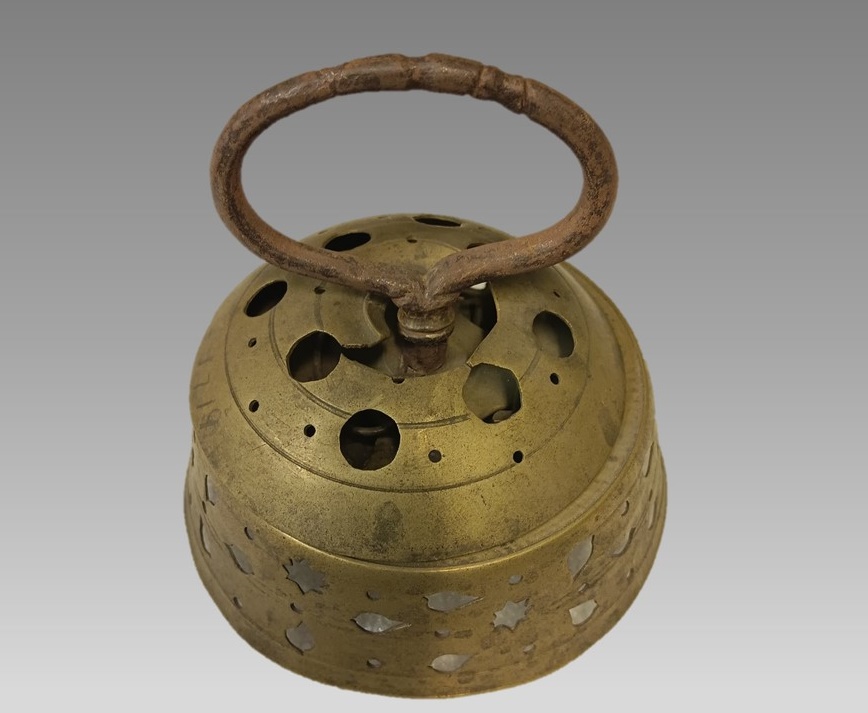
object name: mass bell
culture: belgian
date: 1801-1900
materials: metal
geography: belgium